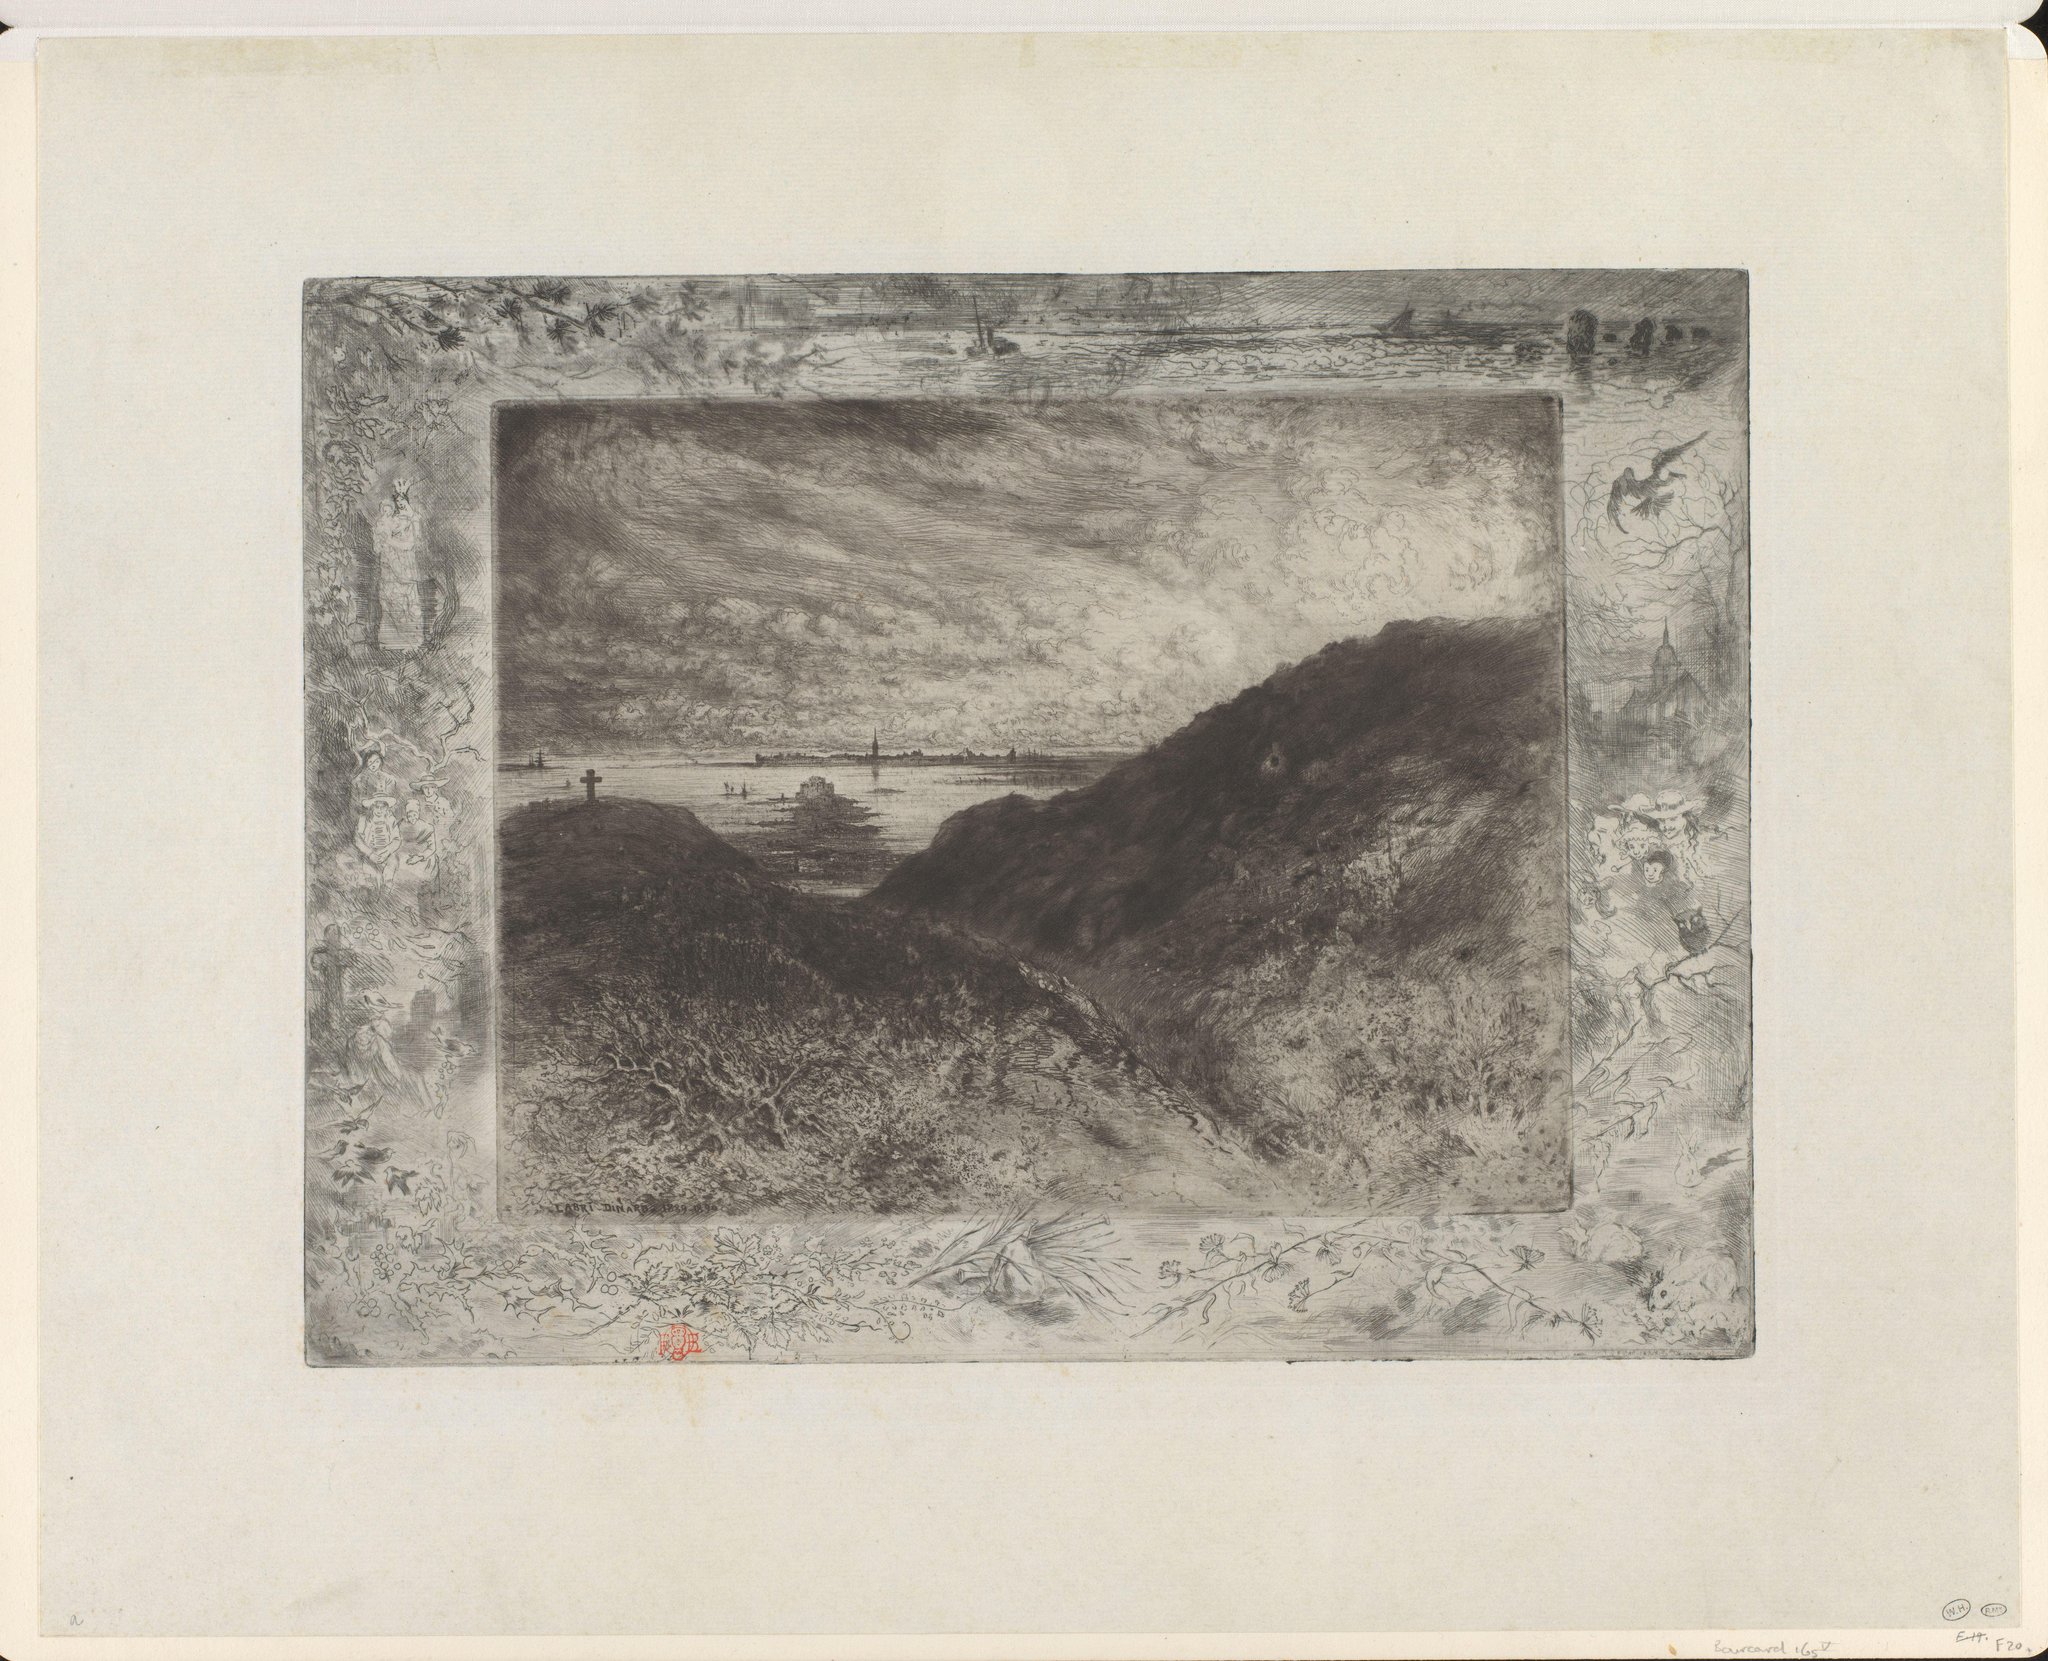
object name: print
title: Duinlandschap met een gezicht op La Falaise, Baie de St. Malo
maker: félix hilaire buhot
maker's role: draughtsman, print maker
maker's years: 1847-1898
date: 1889-1890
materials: paper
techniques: aquatint, drypoint, etching, roulette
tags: gulf, bay, dune coast, cross as symbol of christ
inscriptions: stamp: Lugt 977, collector's mark: Lugt 2228, collector's mark: Lugt 2760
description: Karakteristiek voor Buhot zijn de illustraties die hij in de marges van zijn prenten plaatste, zoals ook bij deze prent het geval is. De inventie die hij "marges symphoniques" noemde, versterkte het hoofdonderwerp van de prent en maakte er integraal deel van uit. Buhot werd geïnspireerd door decoraties in de marges van Middeleeuwse manuscripten en achttiende-eeuwse Franse boekillustraties.